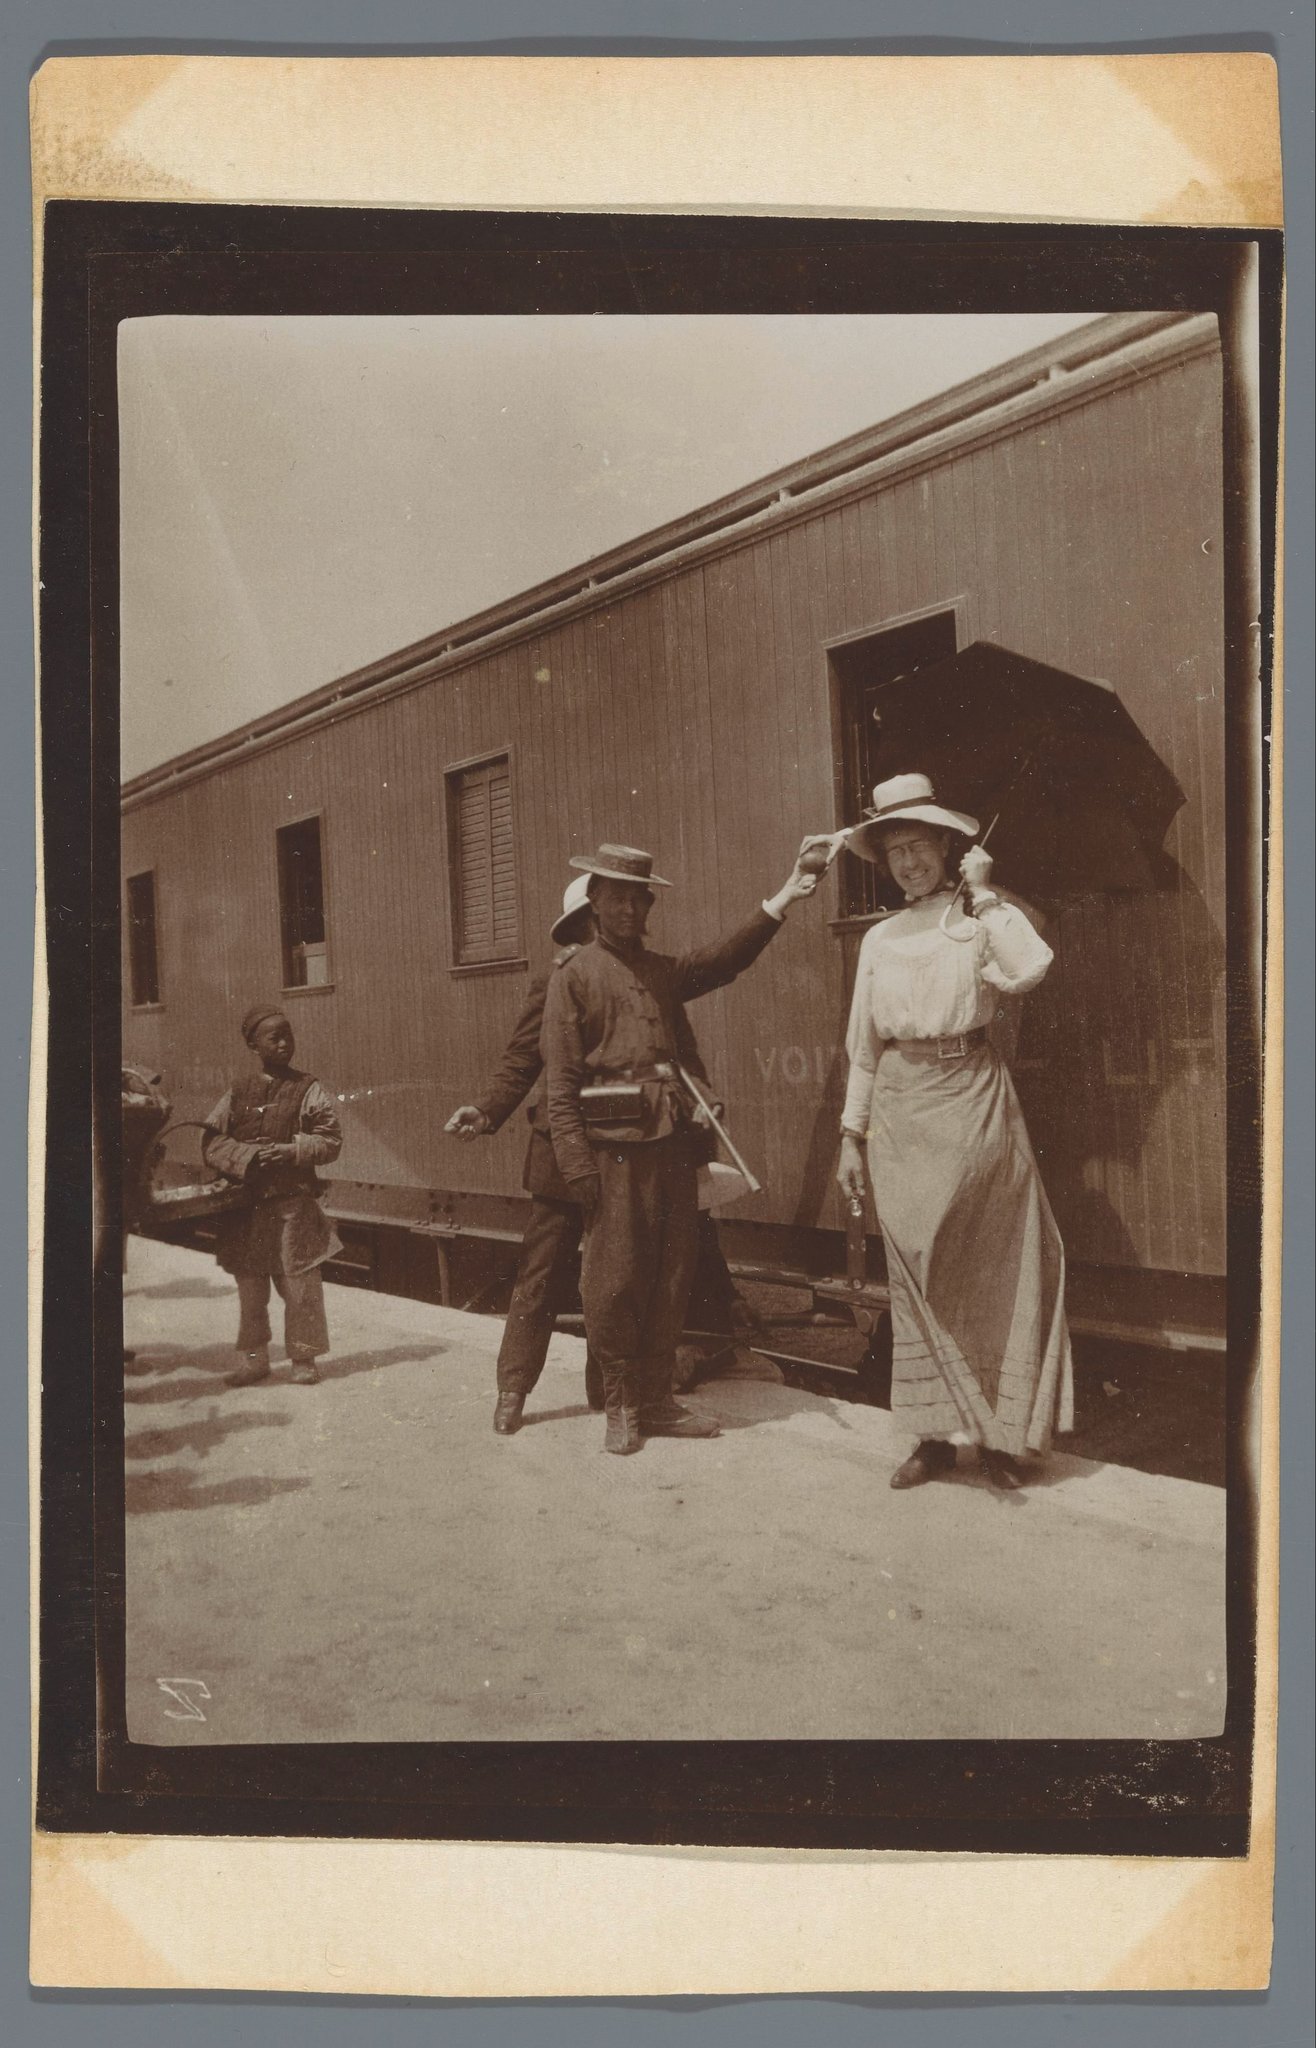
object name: photograph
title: Een vrouw (Miss Ronse) bij de trein van Hankow naar Peking, China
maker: jan adriani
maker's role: fotograaf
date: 1907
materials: paper, photographic support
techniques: collodion silver print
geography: china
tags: passenger train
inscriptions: inscription: ‘[pl]aats hebb op 20 Juni a.s. / Faeylemaborch 6 Juni 1907 / Slochteren (Groningen)’, annotation: ‘Reis Hankow-Peking / Miss Ronse’